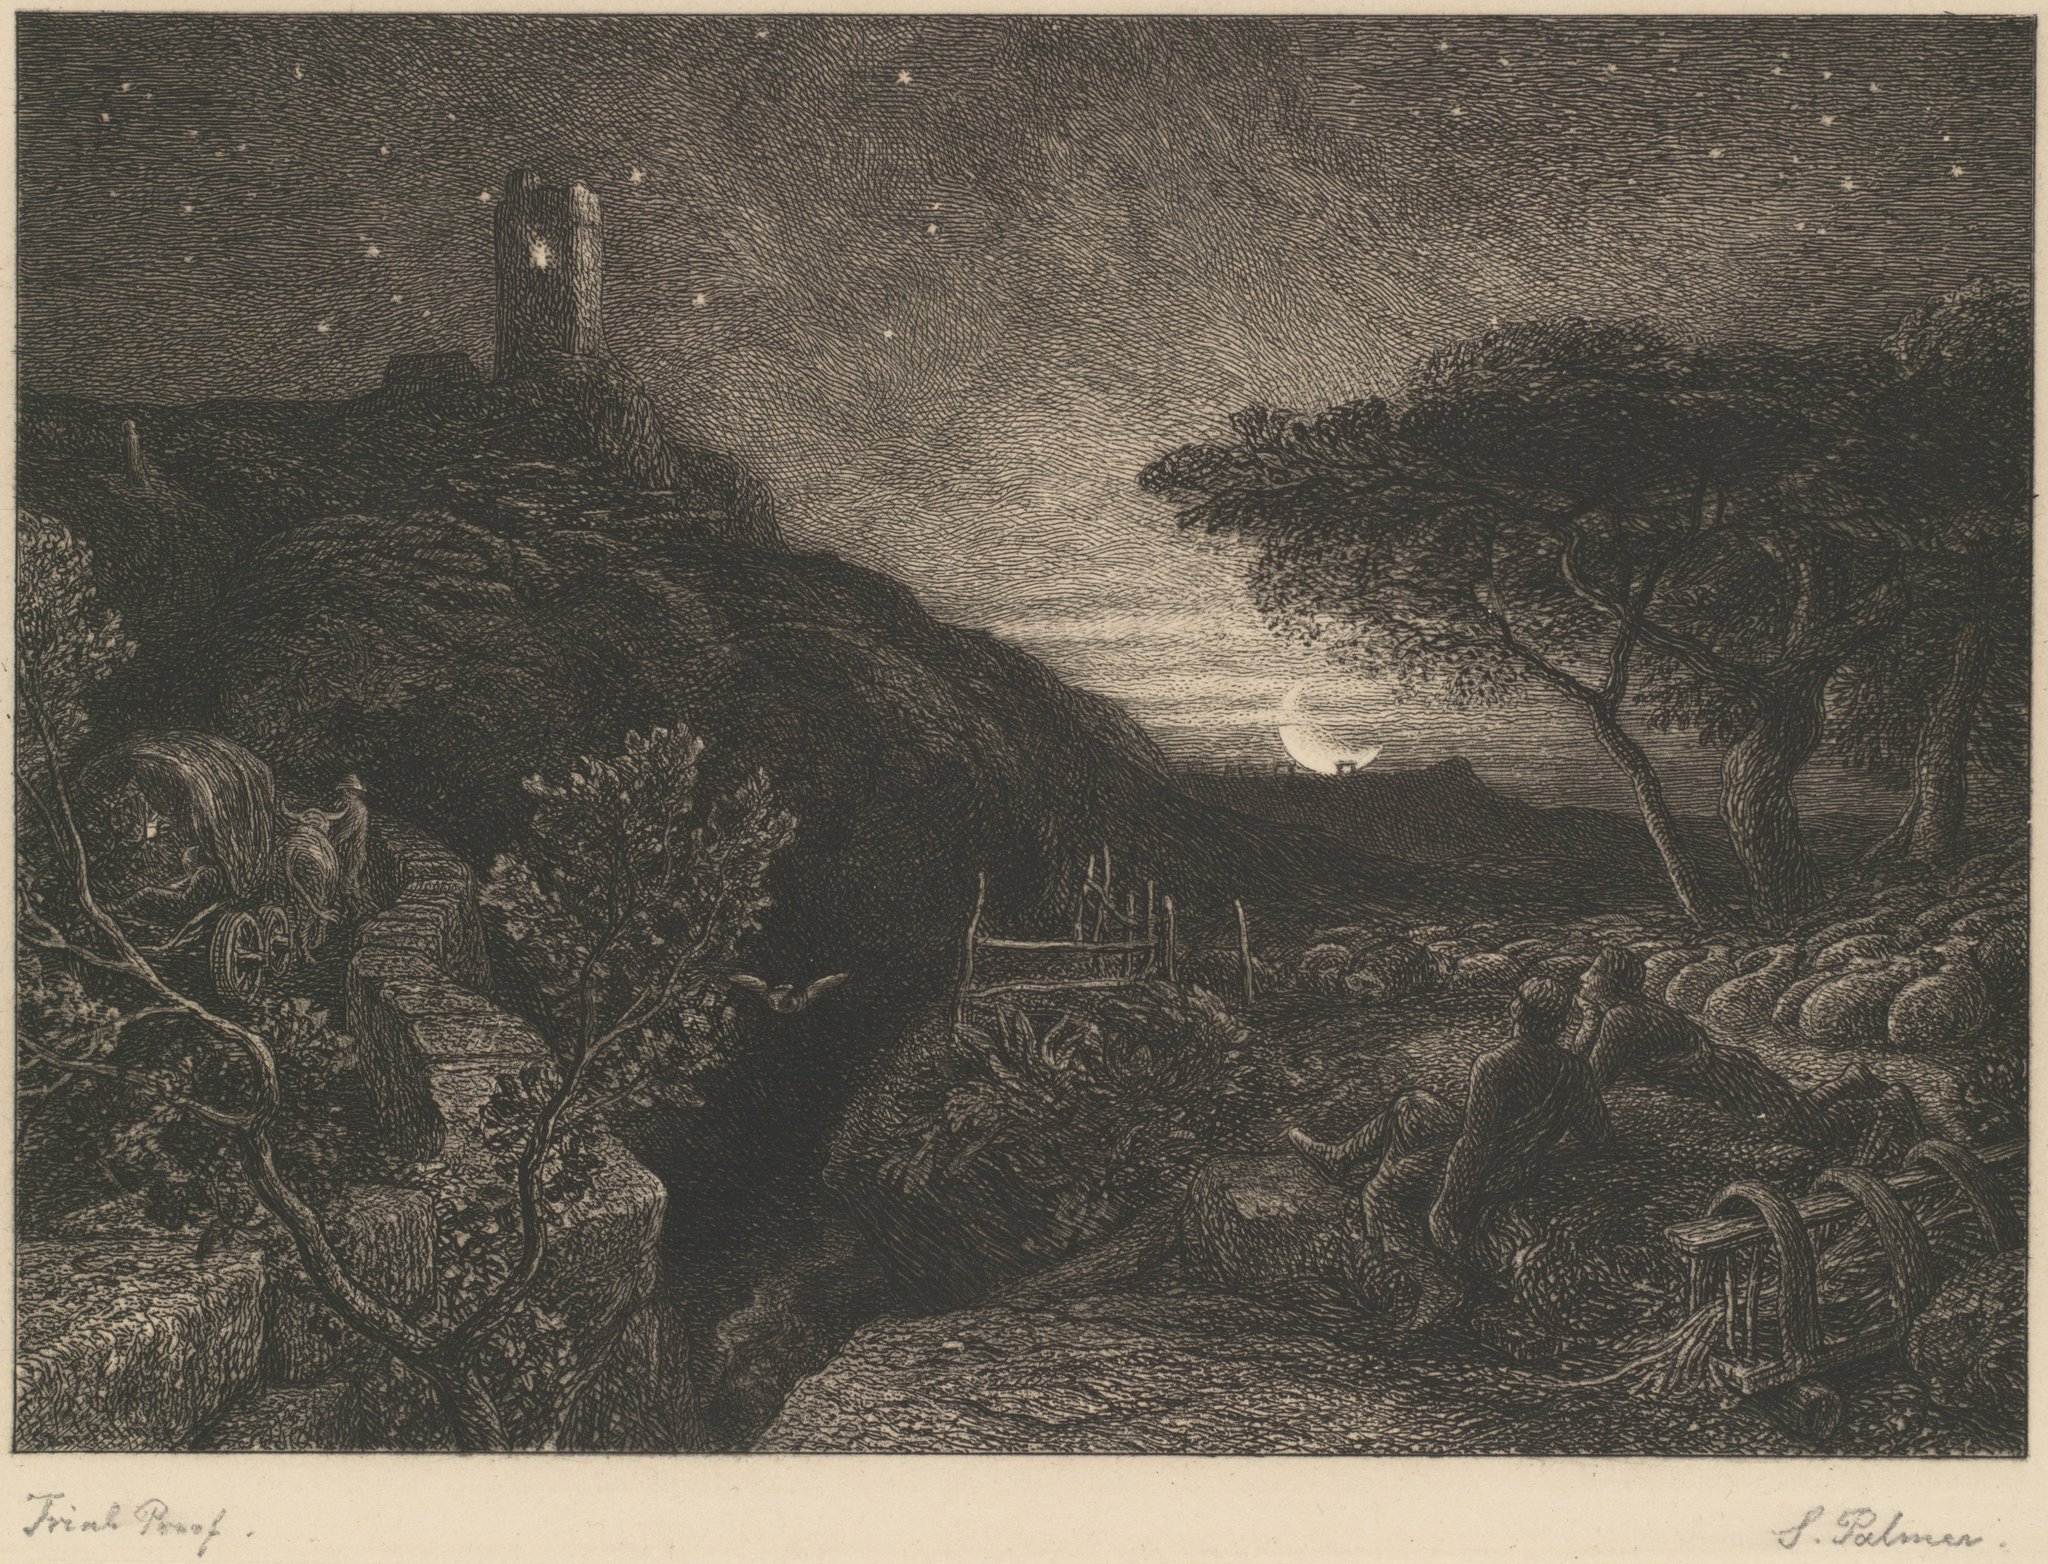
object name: print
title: The Lonely Tower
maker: samuel palmer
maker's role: artist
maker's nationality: british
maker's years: 1805-1881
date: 1879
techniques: etching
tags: towers,moon,trees,night